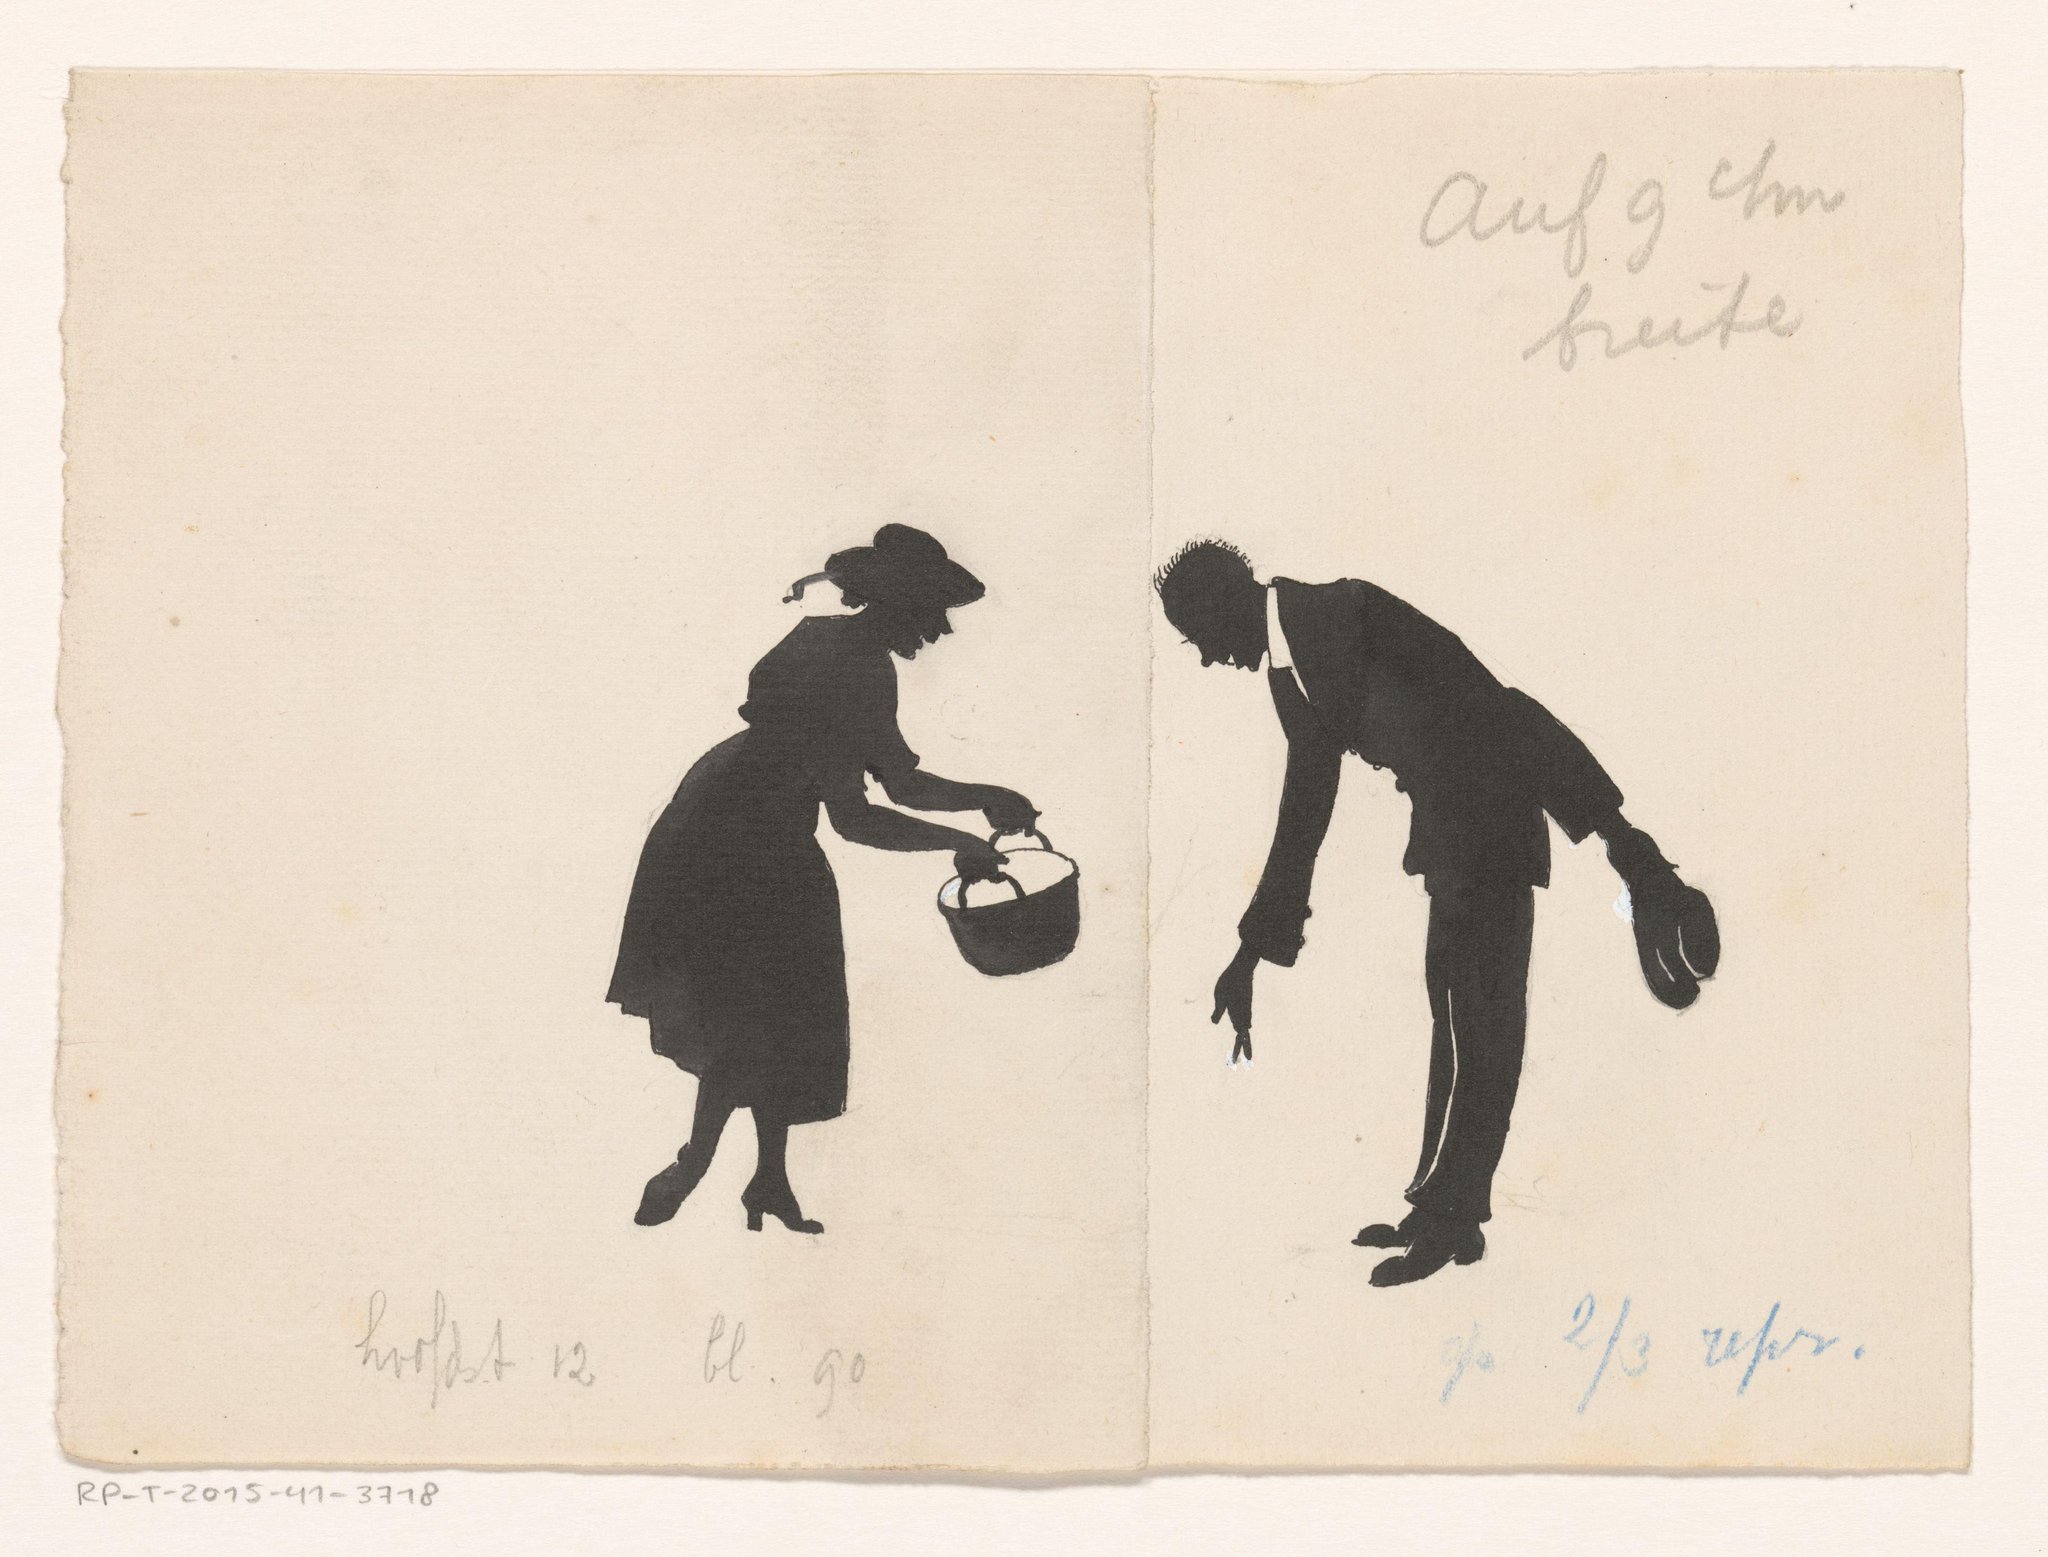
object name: drawing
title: Vrouw met teil tegenover een wijzende man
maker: Anonymous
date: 1900-1930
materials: paint, ink, paper, pencil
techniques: brush, pen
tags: bowl, index finger forwards, pointing, indicating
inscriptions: collector's mark: Lugt 2228a, annotation: ‘hoofds 12 bl. 90’, :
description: Een vrouw houdt een teil met twee handen vast. Ze staat tegenover een man in pak die met zijn rechterhand naar de grond gebaart. Aan zijn linkerhand draagt de man vermoedelijk een (boks)handschoen.